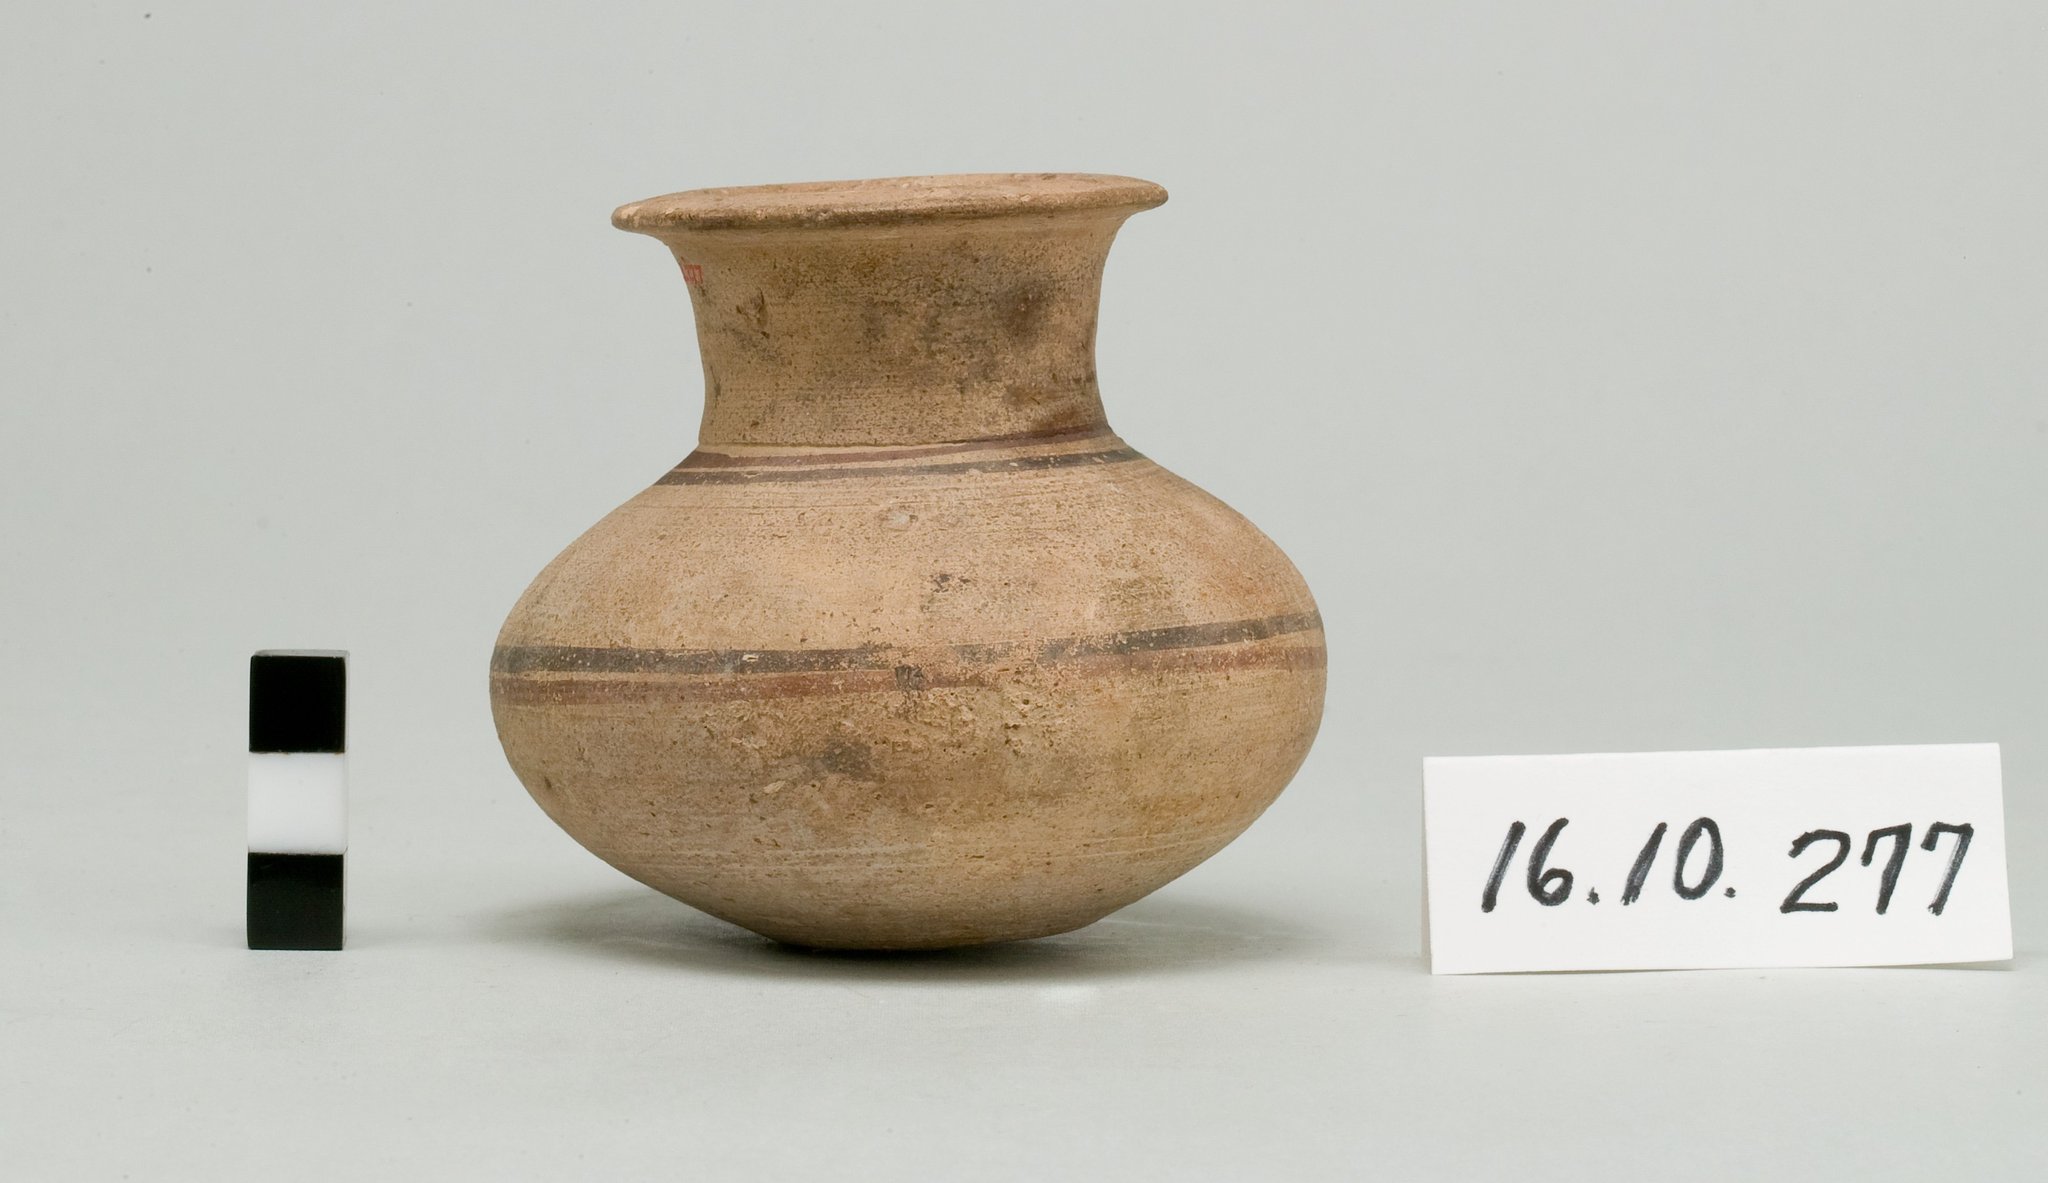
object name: jar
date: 1550-1458 BCE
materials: pottery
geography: egypt